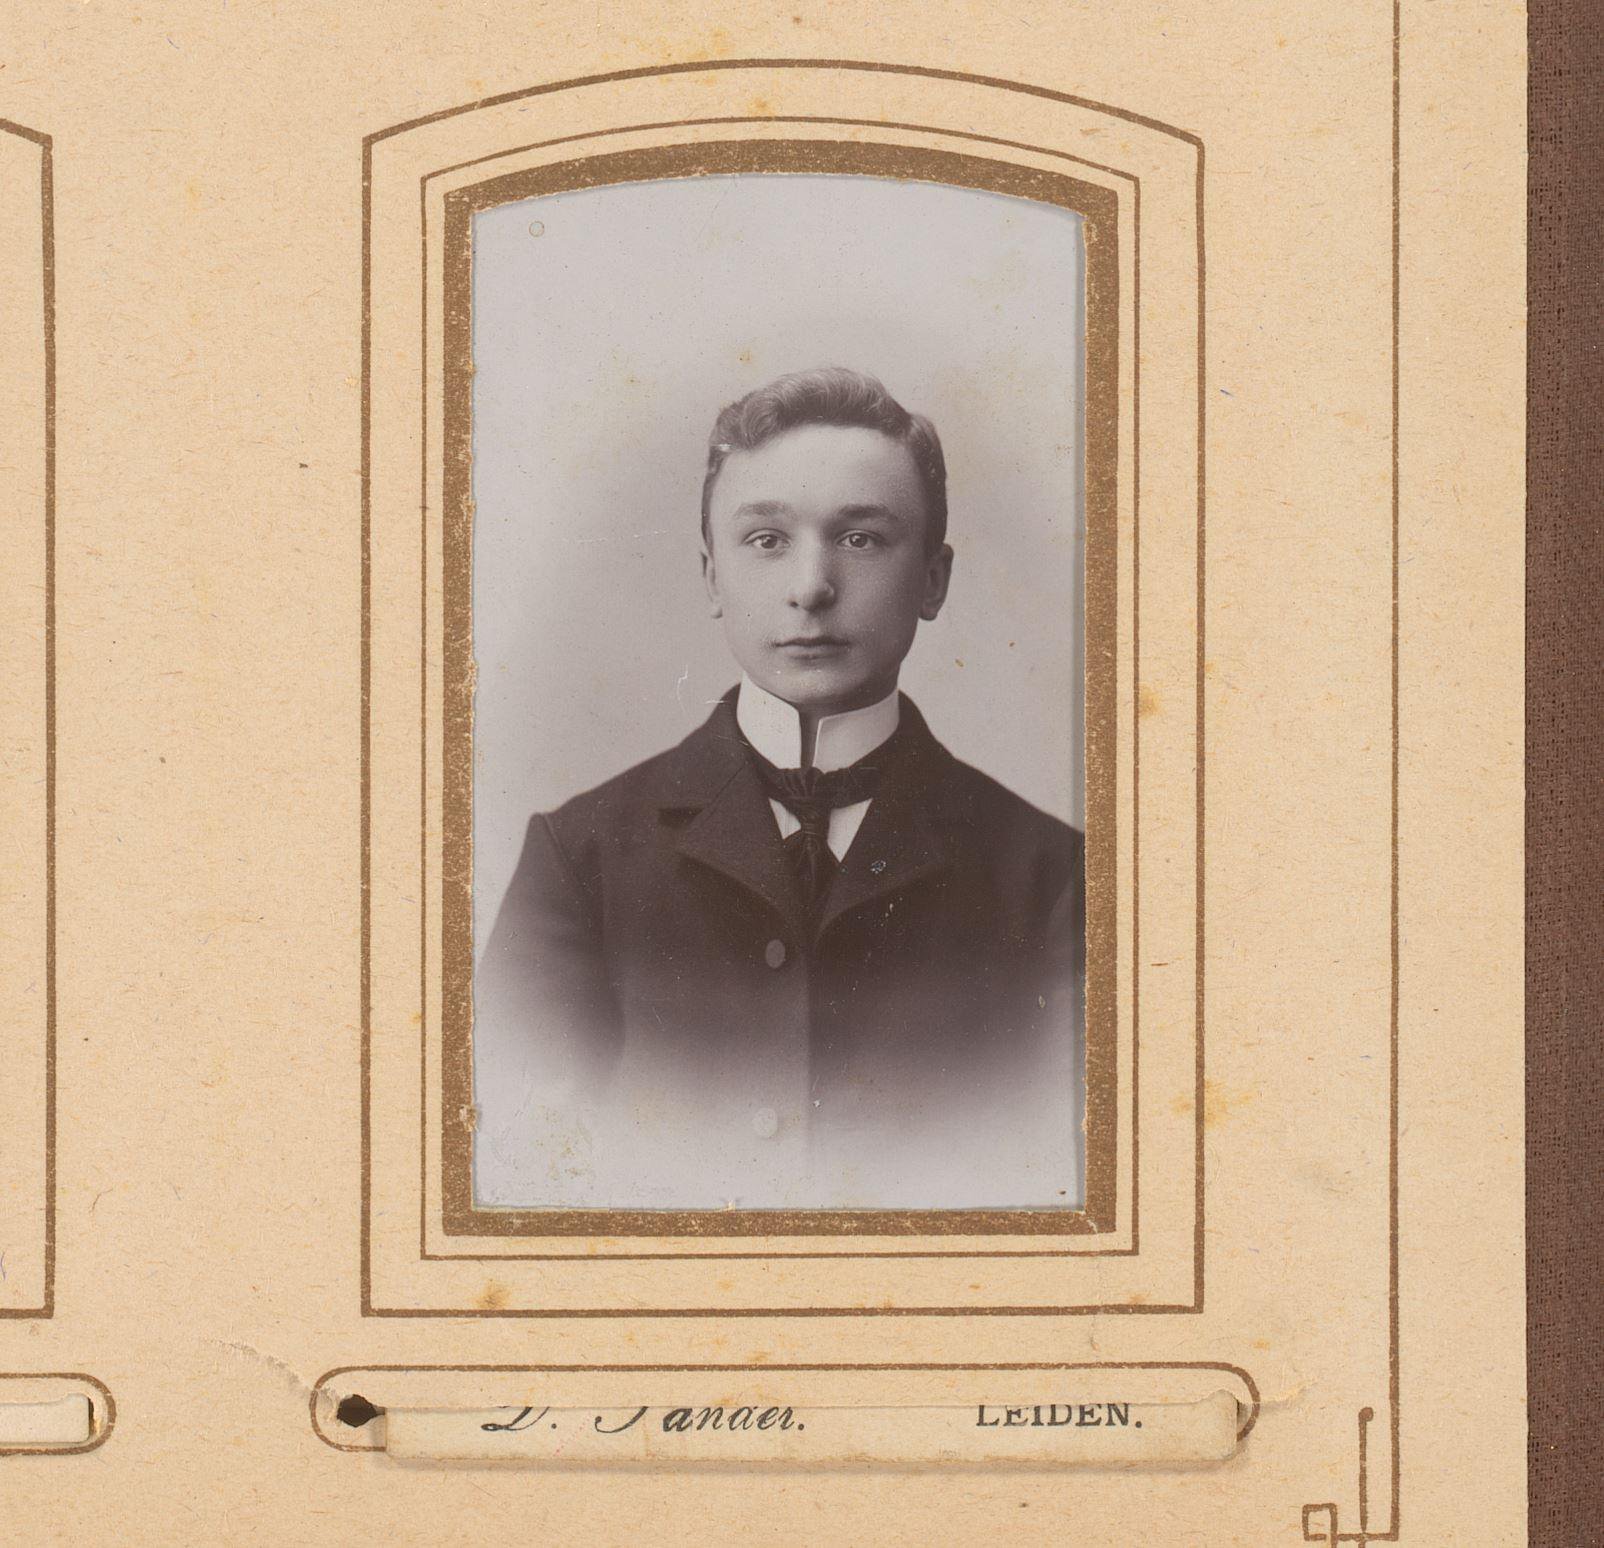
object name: photograph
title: Portret van een jongeman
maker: dirk pander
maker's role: fotograaf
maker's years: 1877-1941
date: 1880-1920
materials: cardboard, photographic support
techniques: collodion silver print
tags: historical persons, youth, adolescent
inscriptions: annotation: ‘[...]’